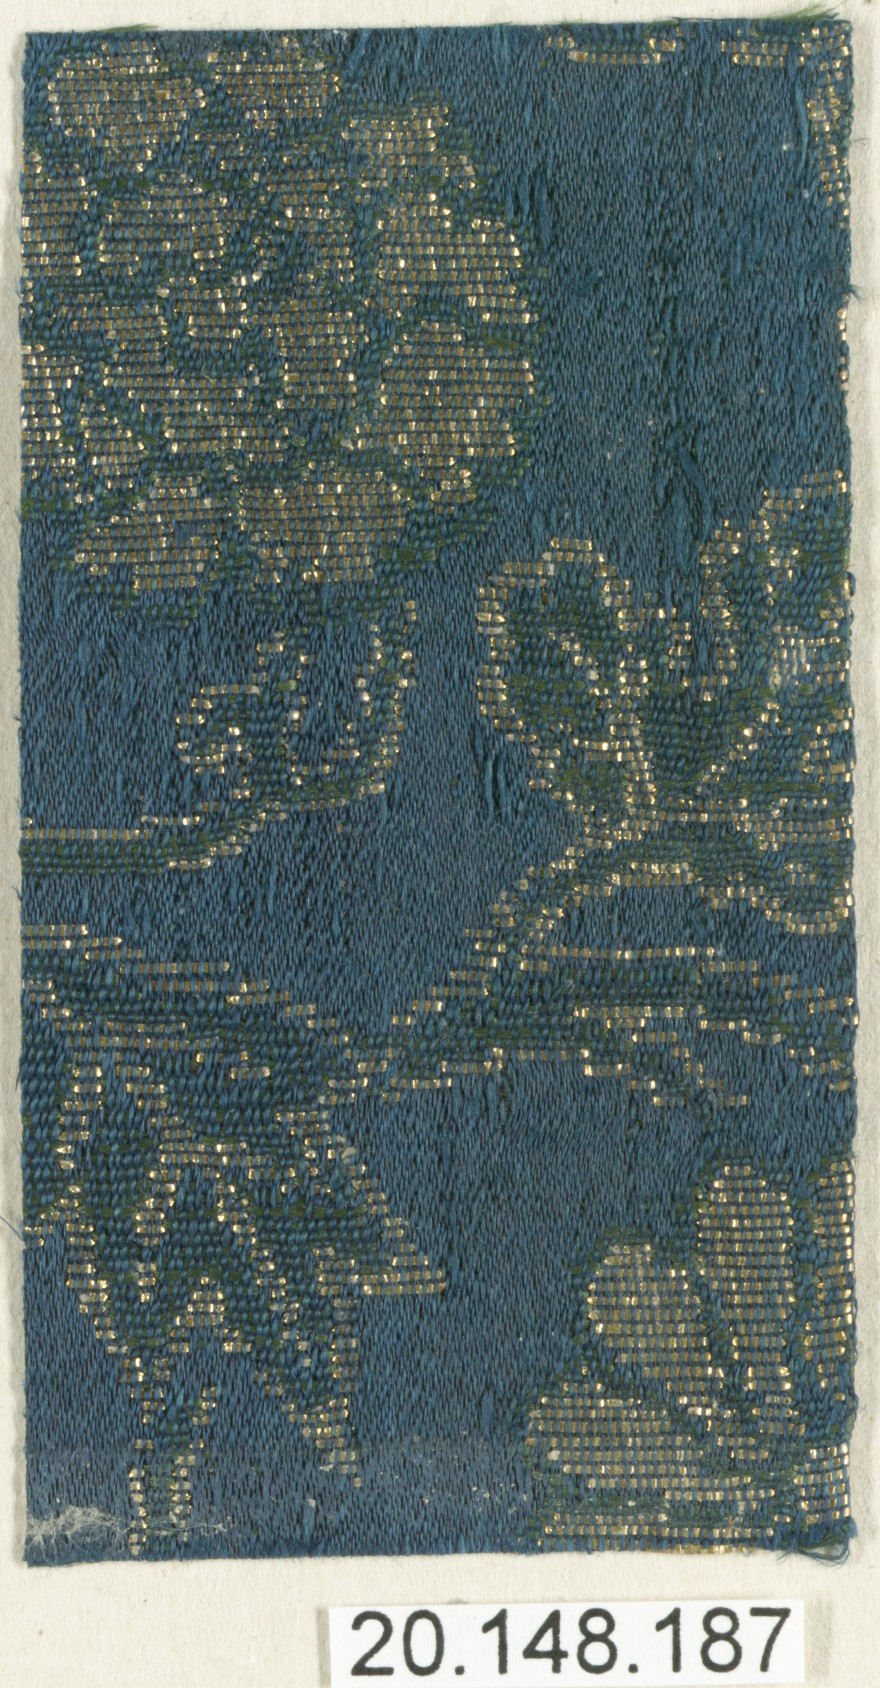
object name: piece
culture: japanese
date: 1701-1800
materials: silk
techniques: compound weave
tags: flowers,leaves